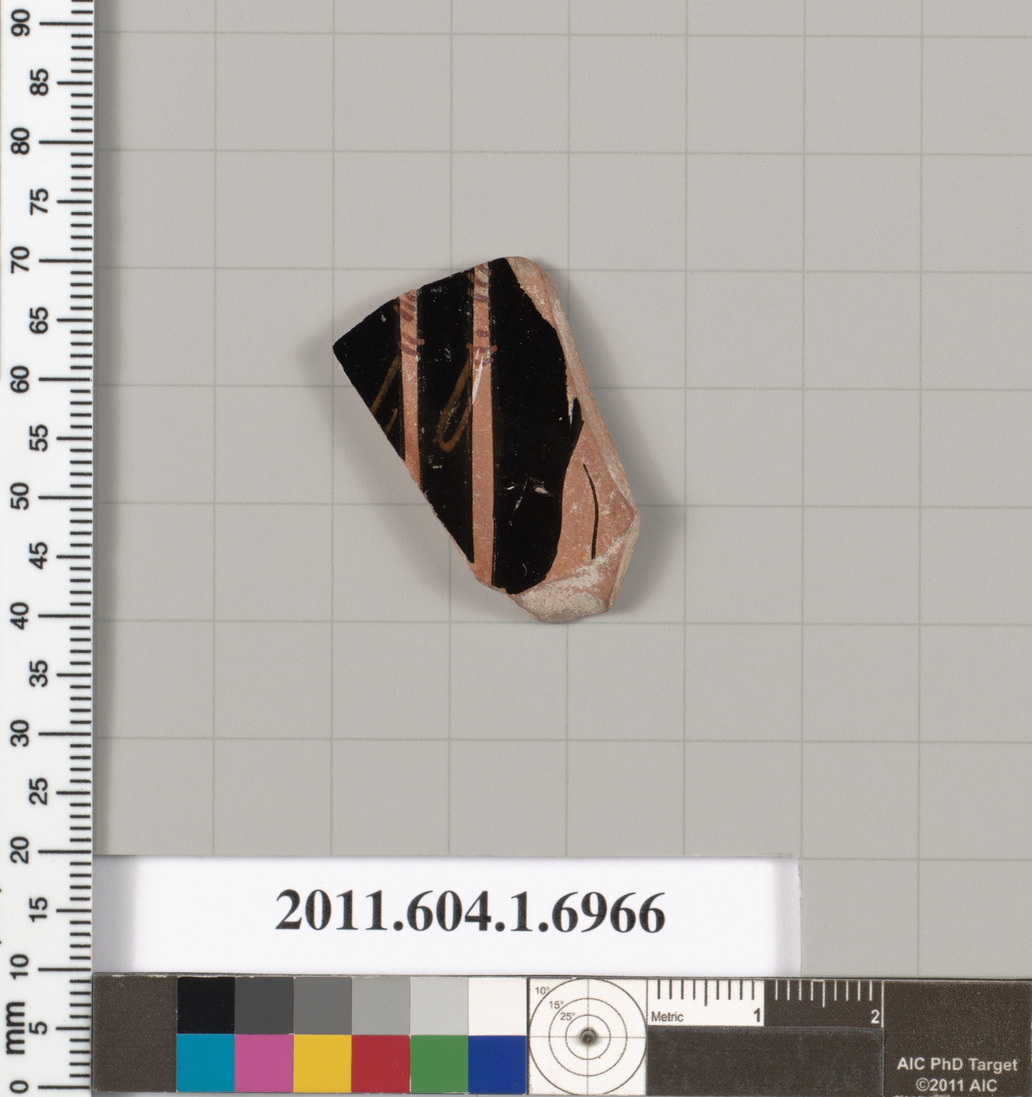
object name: kylix fragment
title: Terracotta fragment of a kylix (drinking cup)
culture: greek, attic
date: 490-470 BCE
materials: terracotta